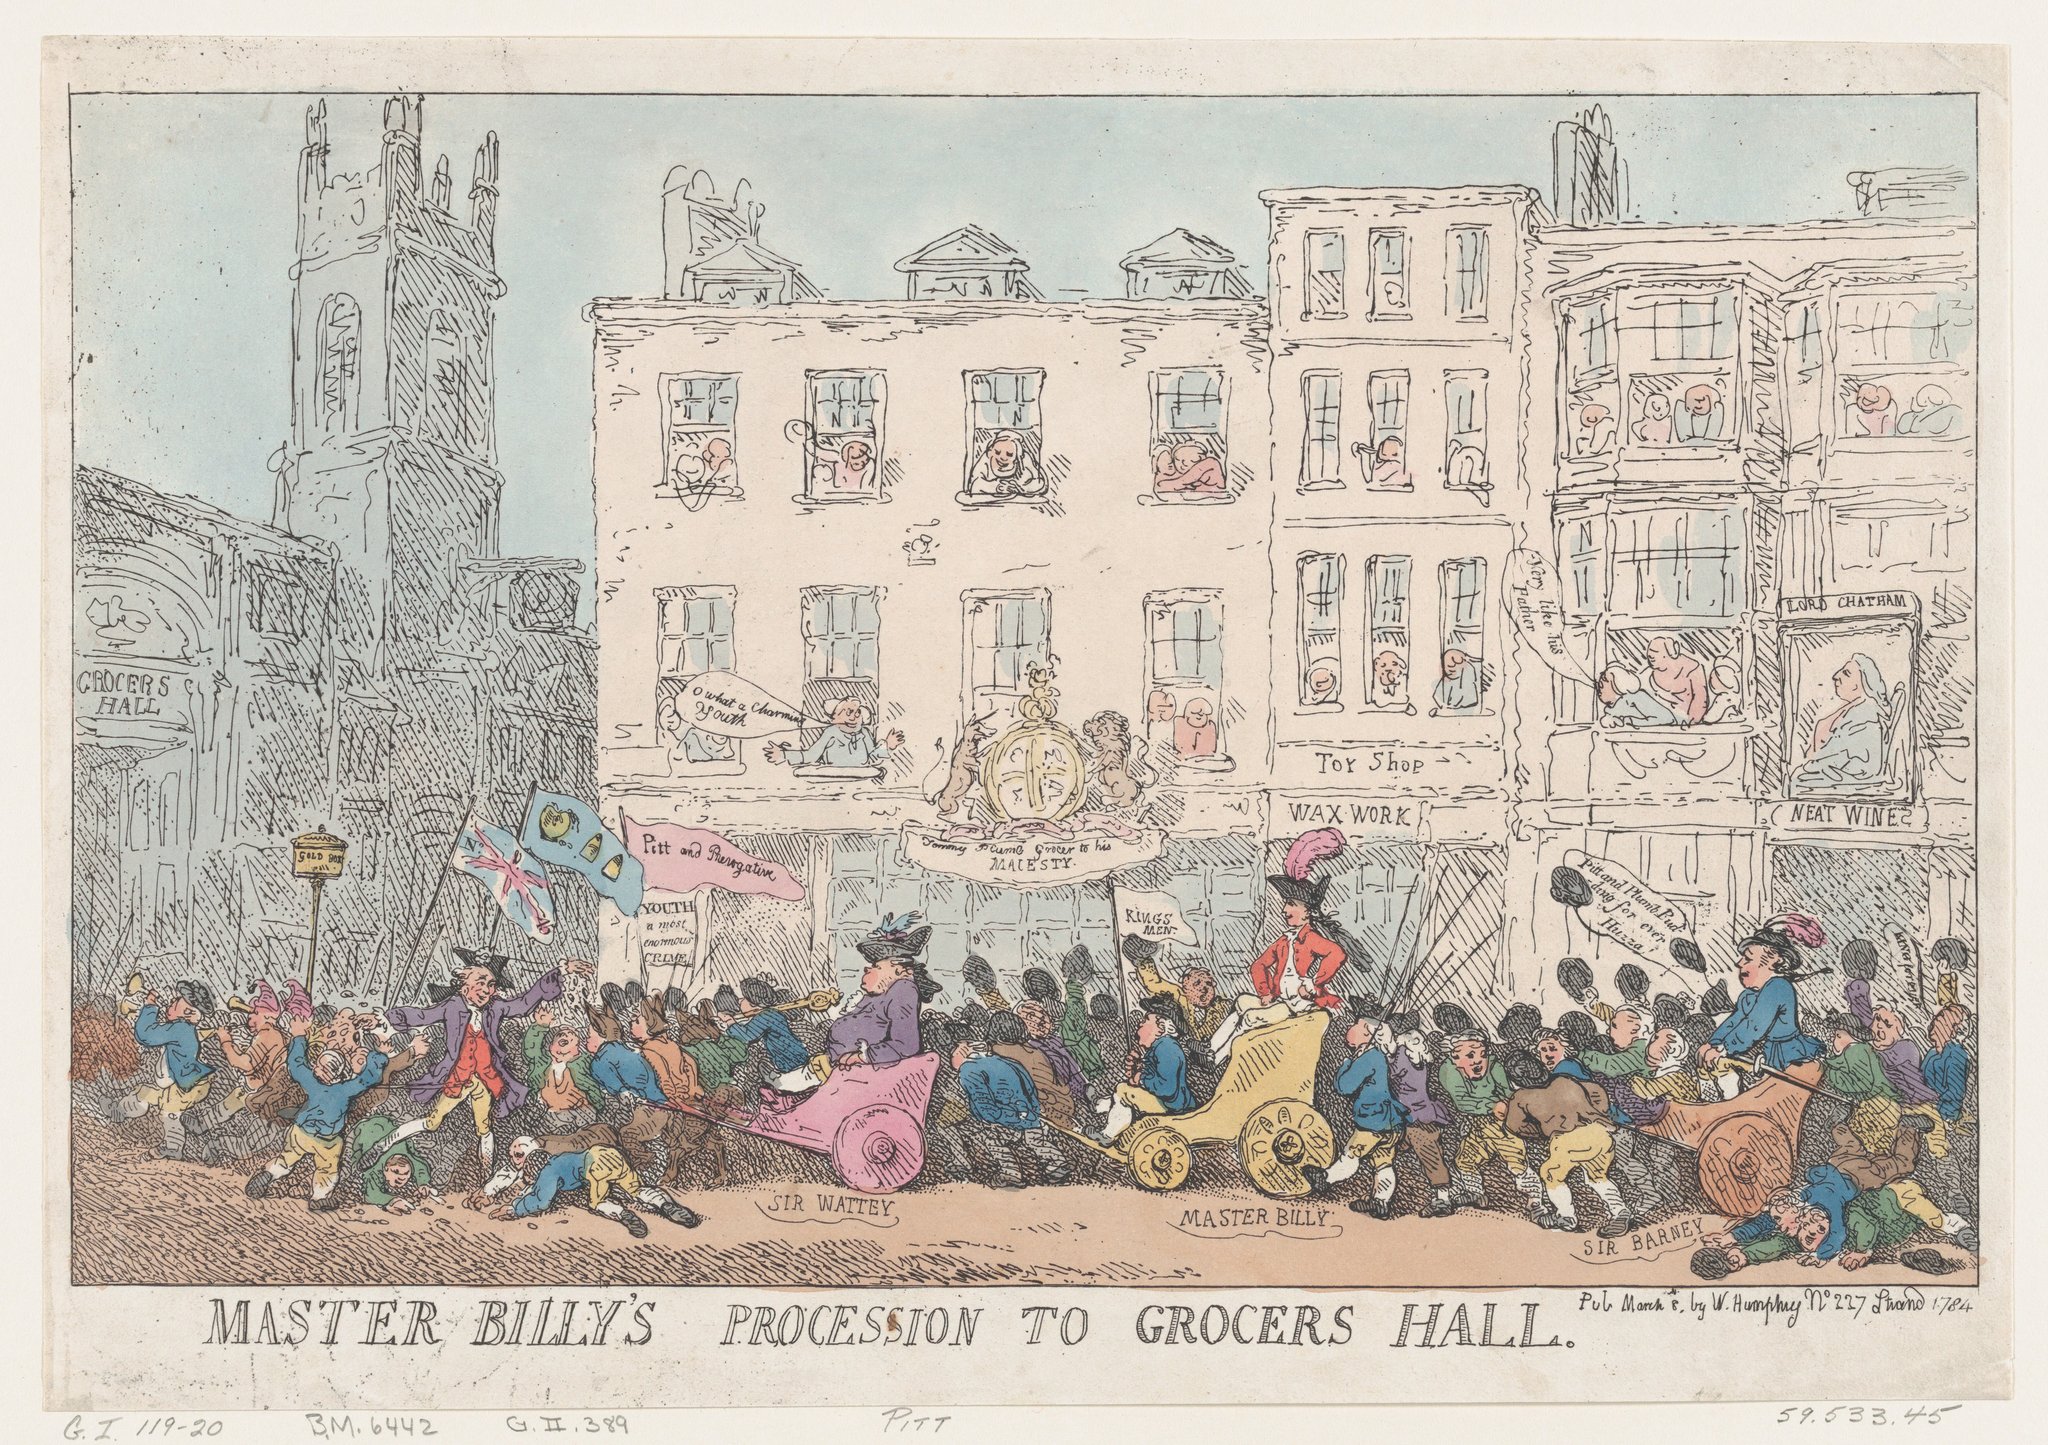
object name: print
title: Master Billy's Procession to Grocers Hall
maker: thomas rowlandson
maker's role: artist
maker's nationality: british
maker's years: 1757-1827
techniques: etching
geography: london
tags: satire,buildings,men,carriages